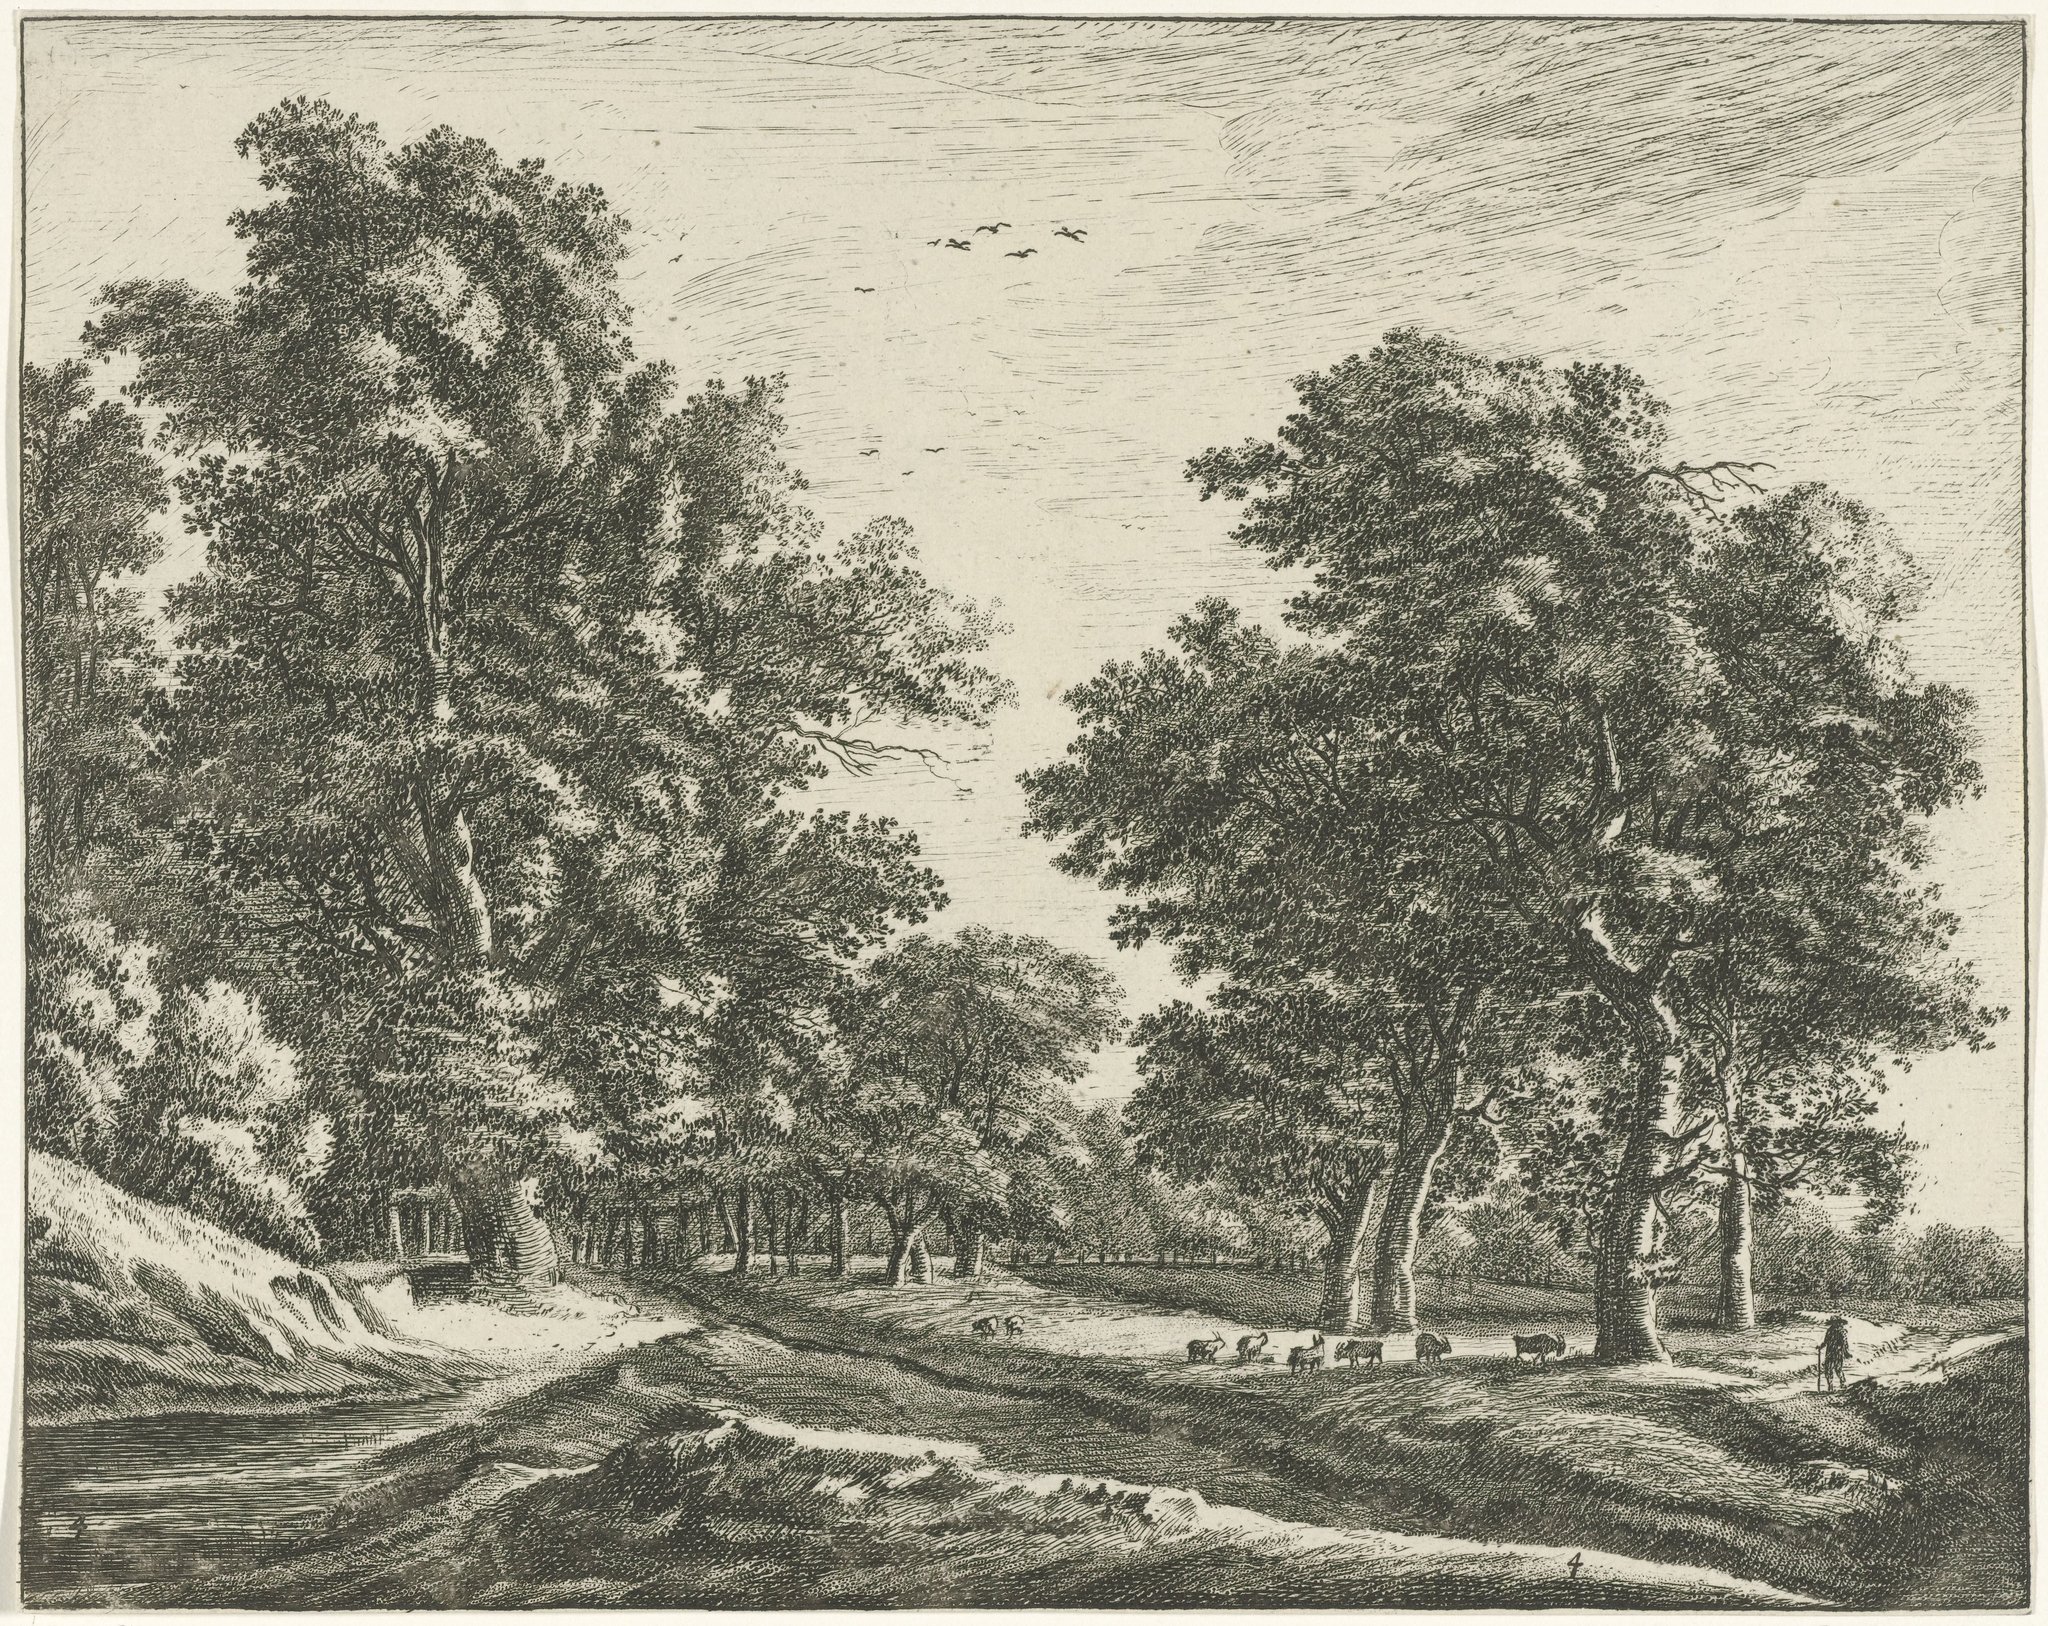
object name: print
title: Gezichten in het Haagse Bos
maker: roelant roghman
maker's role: draughtsman, painter, print maker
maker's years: 1627-1692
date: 1637-1742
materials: paper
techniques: etching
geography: amsterdam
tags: forest, wood, glade, 'lichtung im wald', forest path or lane, goat, 'en route', traveller under way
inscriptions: collector's mark: Lugt 2228a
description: Op een open plek in het Haagse Bos grazen enkele geiten. Langs de plek loopt een pad. Rechts een wandelaar.